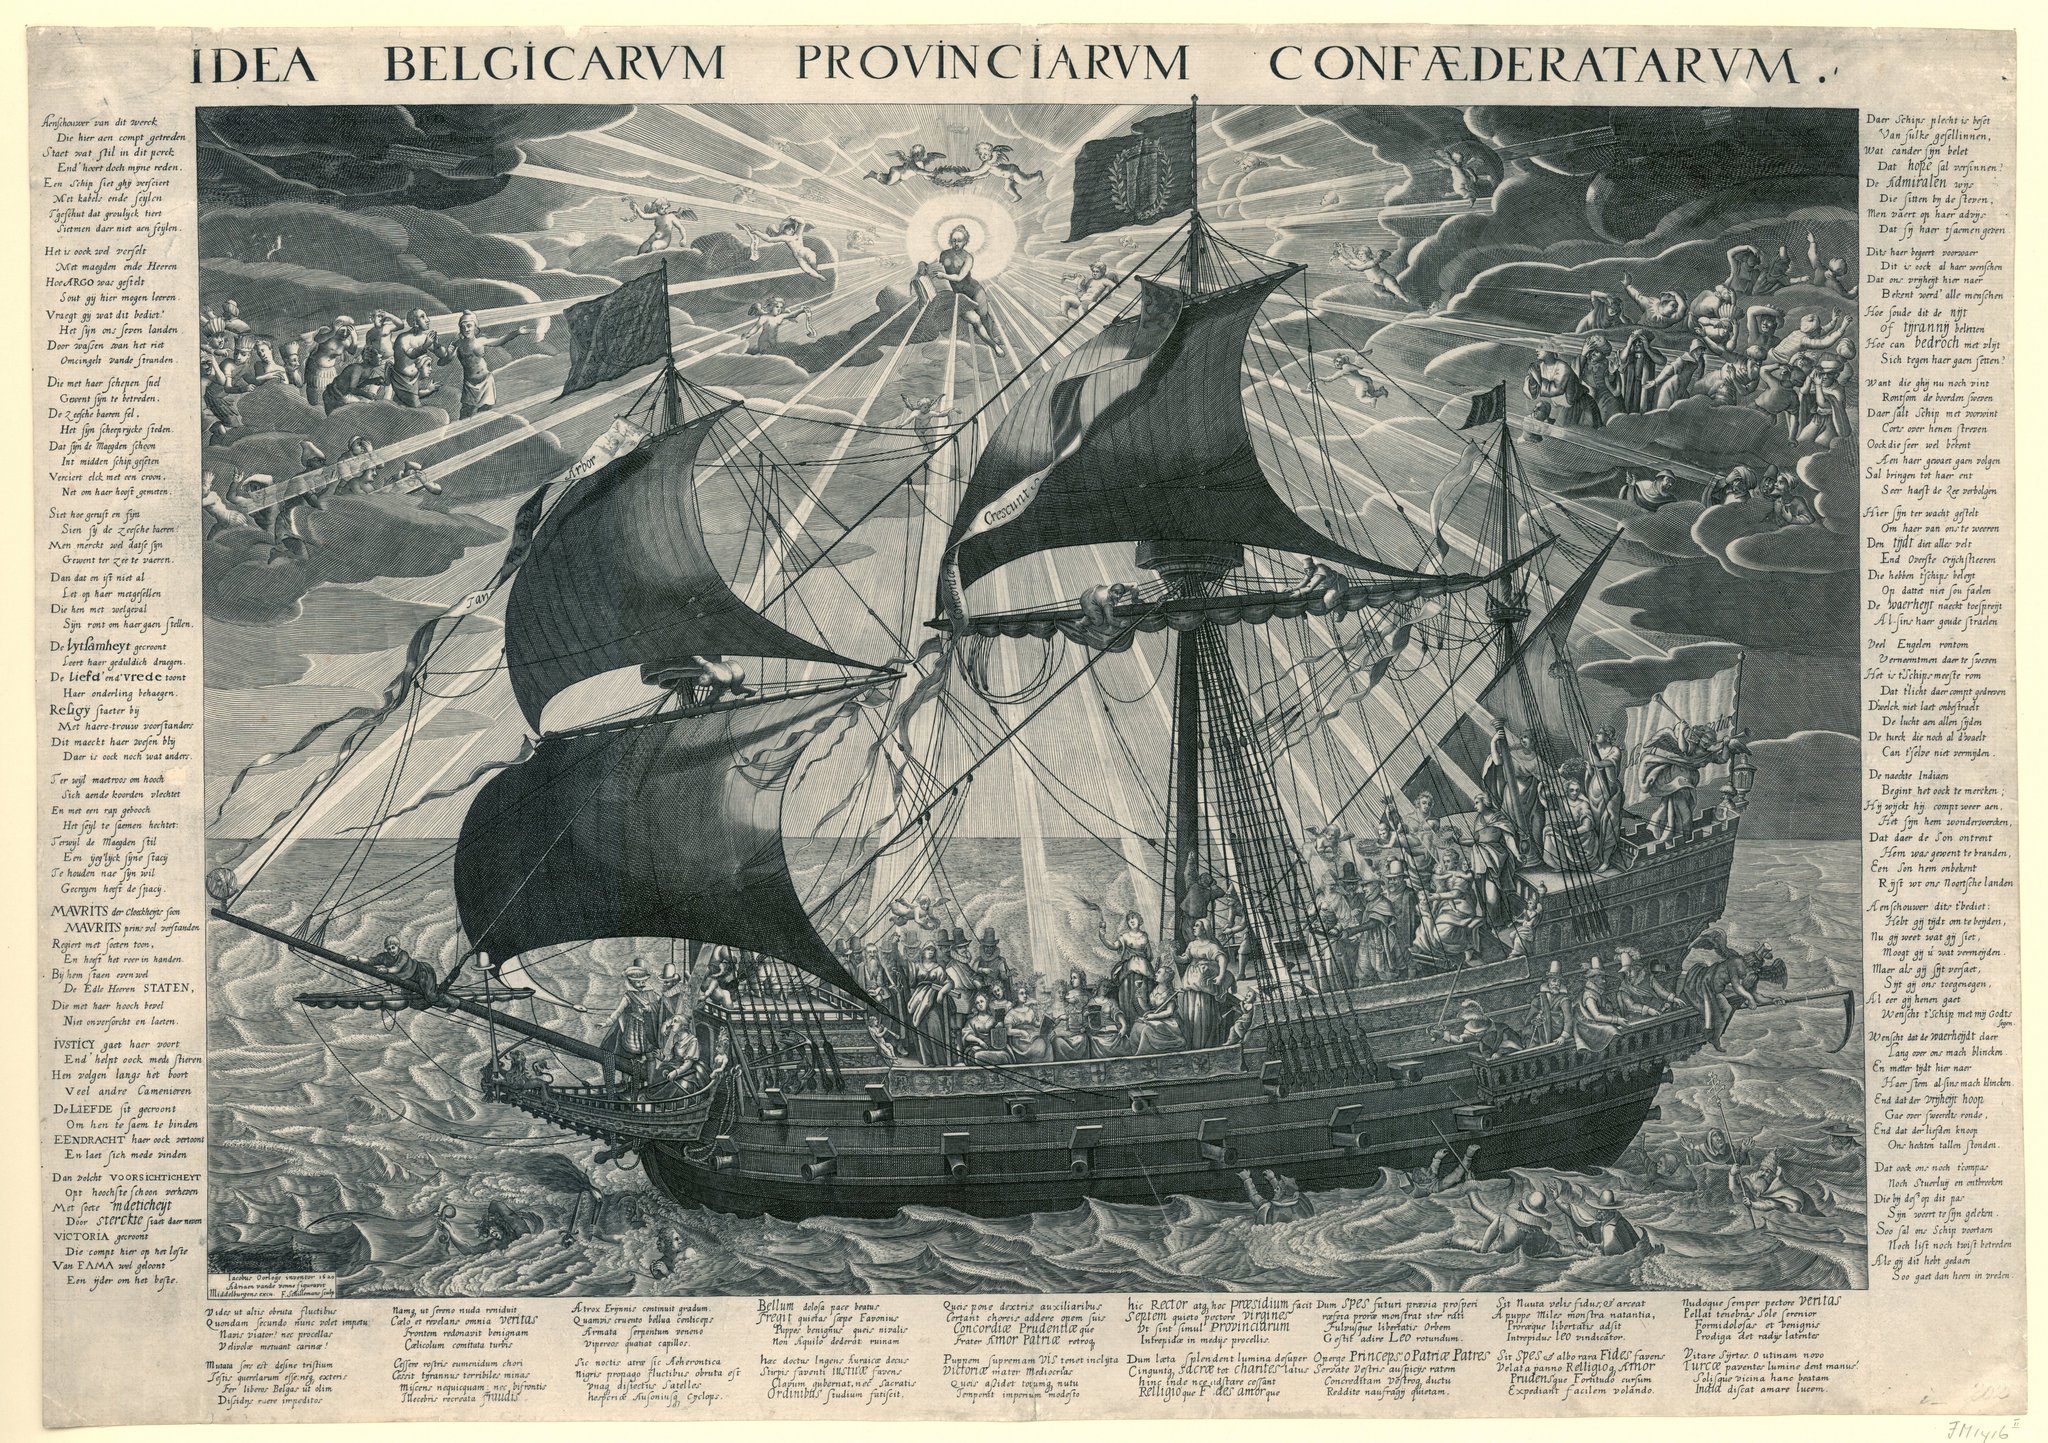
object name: print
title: Allegorie op de gelukkige staat van het land na de synode van Dordrecht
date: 1620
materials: paper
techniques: engraving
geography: middelburg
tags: the hague, maurice (prince of orange), ships (in general) (+ propulsion of vehicle, ship, etc. by wind), 'sapientia' and the seven virtues, i.e. the three theological and the four cardinal virtues, africans, non-european white peoples, native peoples of the americas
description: Het Schip van Staat. Allegorie op de gelukkige staat van het land na de synode van Dordrecht, 1620. Het Schip van Staat vaart in rustig water, met aan boord de zeven provinciemaagden en personificaties van deugden. Prins Maurits en Justitia staan aan het roer. In het water spartelen de katholieken en personificaties van ondeugden. In de hemel worden volkeren van de wereld, waaronder oorspronkelijke Amerikanen, Afrikanen en mannen met tulband, verblind door het stralende licht van de naakte Waarheid met een bijbel. Bovenaan de titel, links en rechts Nederlandse verzen, onderaan een Latijns vers.